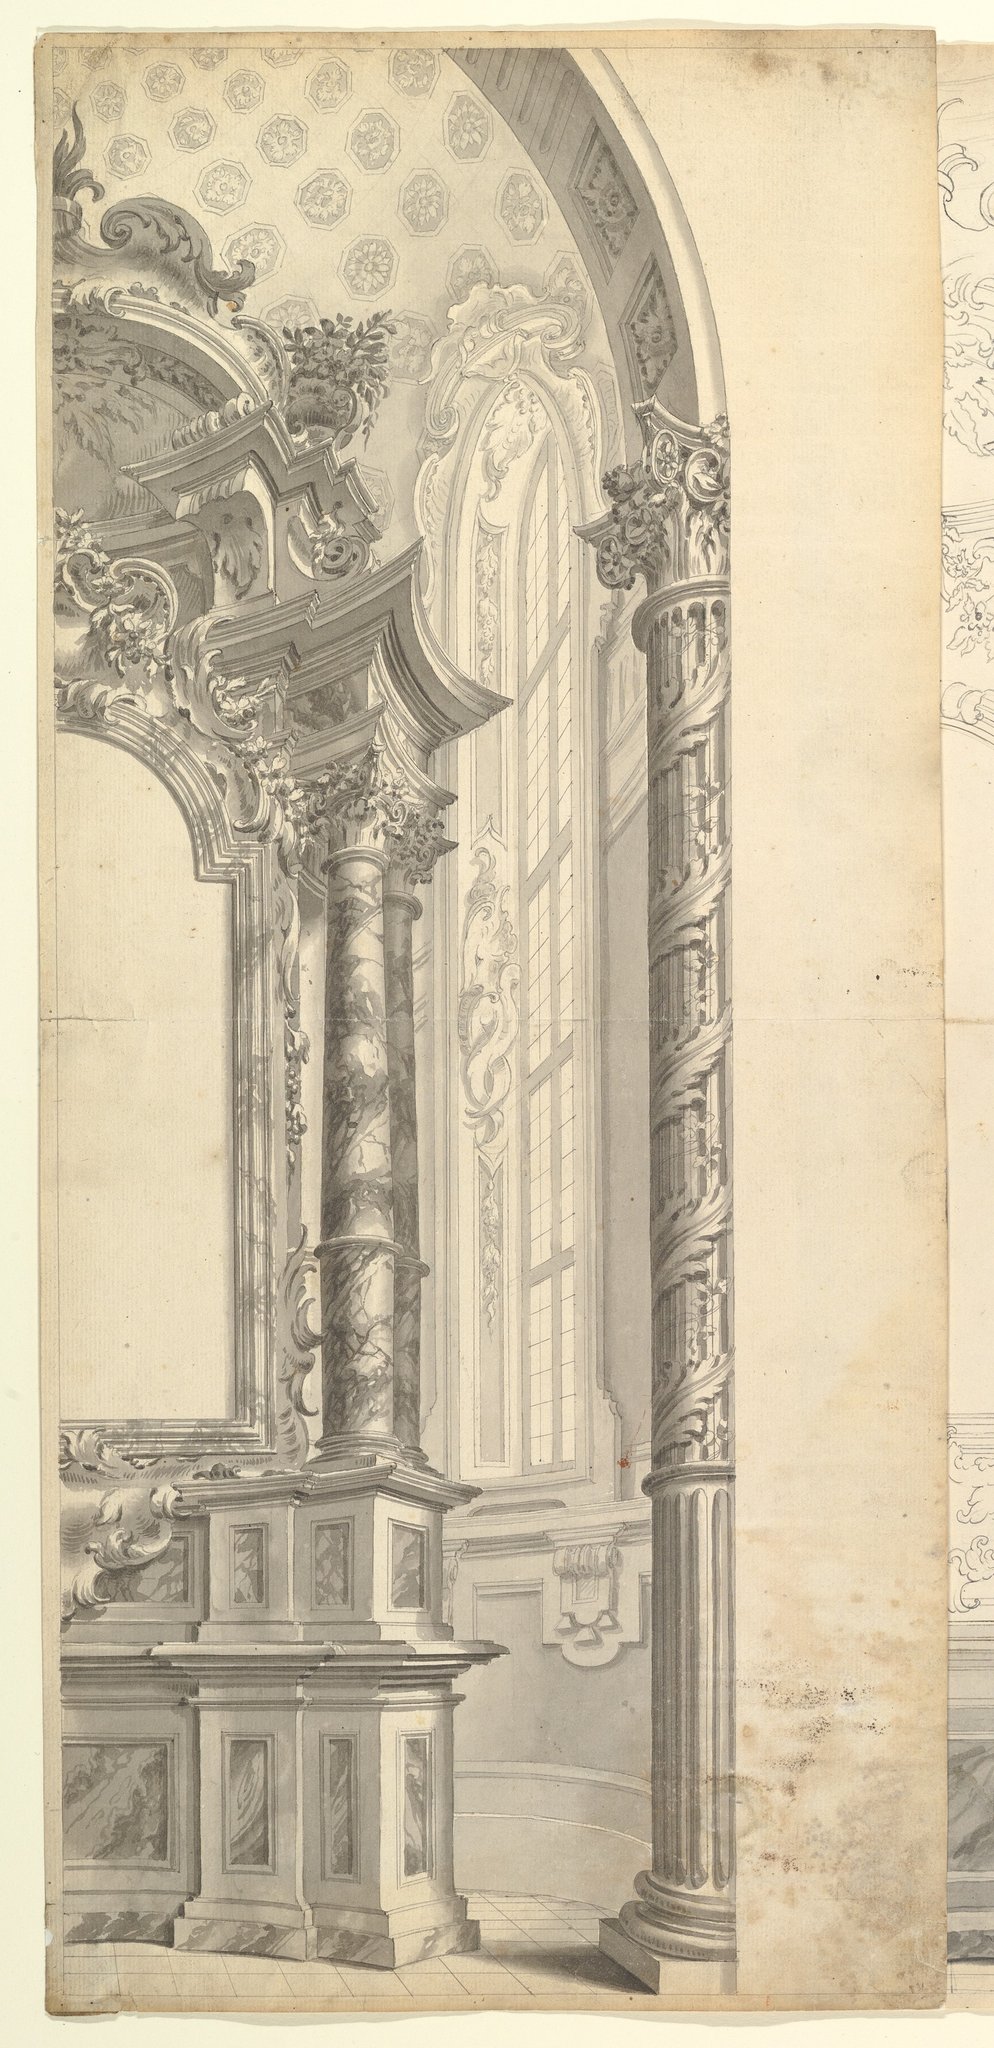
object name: drawing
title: Halved Design for an Altar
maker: anonymous, italian, piedmontese, 18th century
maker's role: artist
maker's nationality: italian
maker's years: 1700-1800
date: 1700-1780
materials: graphite, ink, drawing material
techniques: brush, pen, wash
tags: architecture,altars